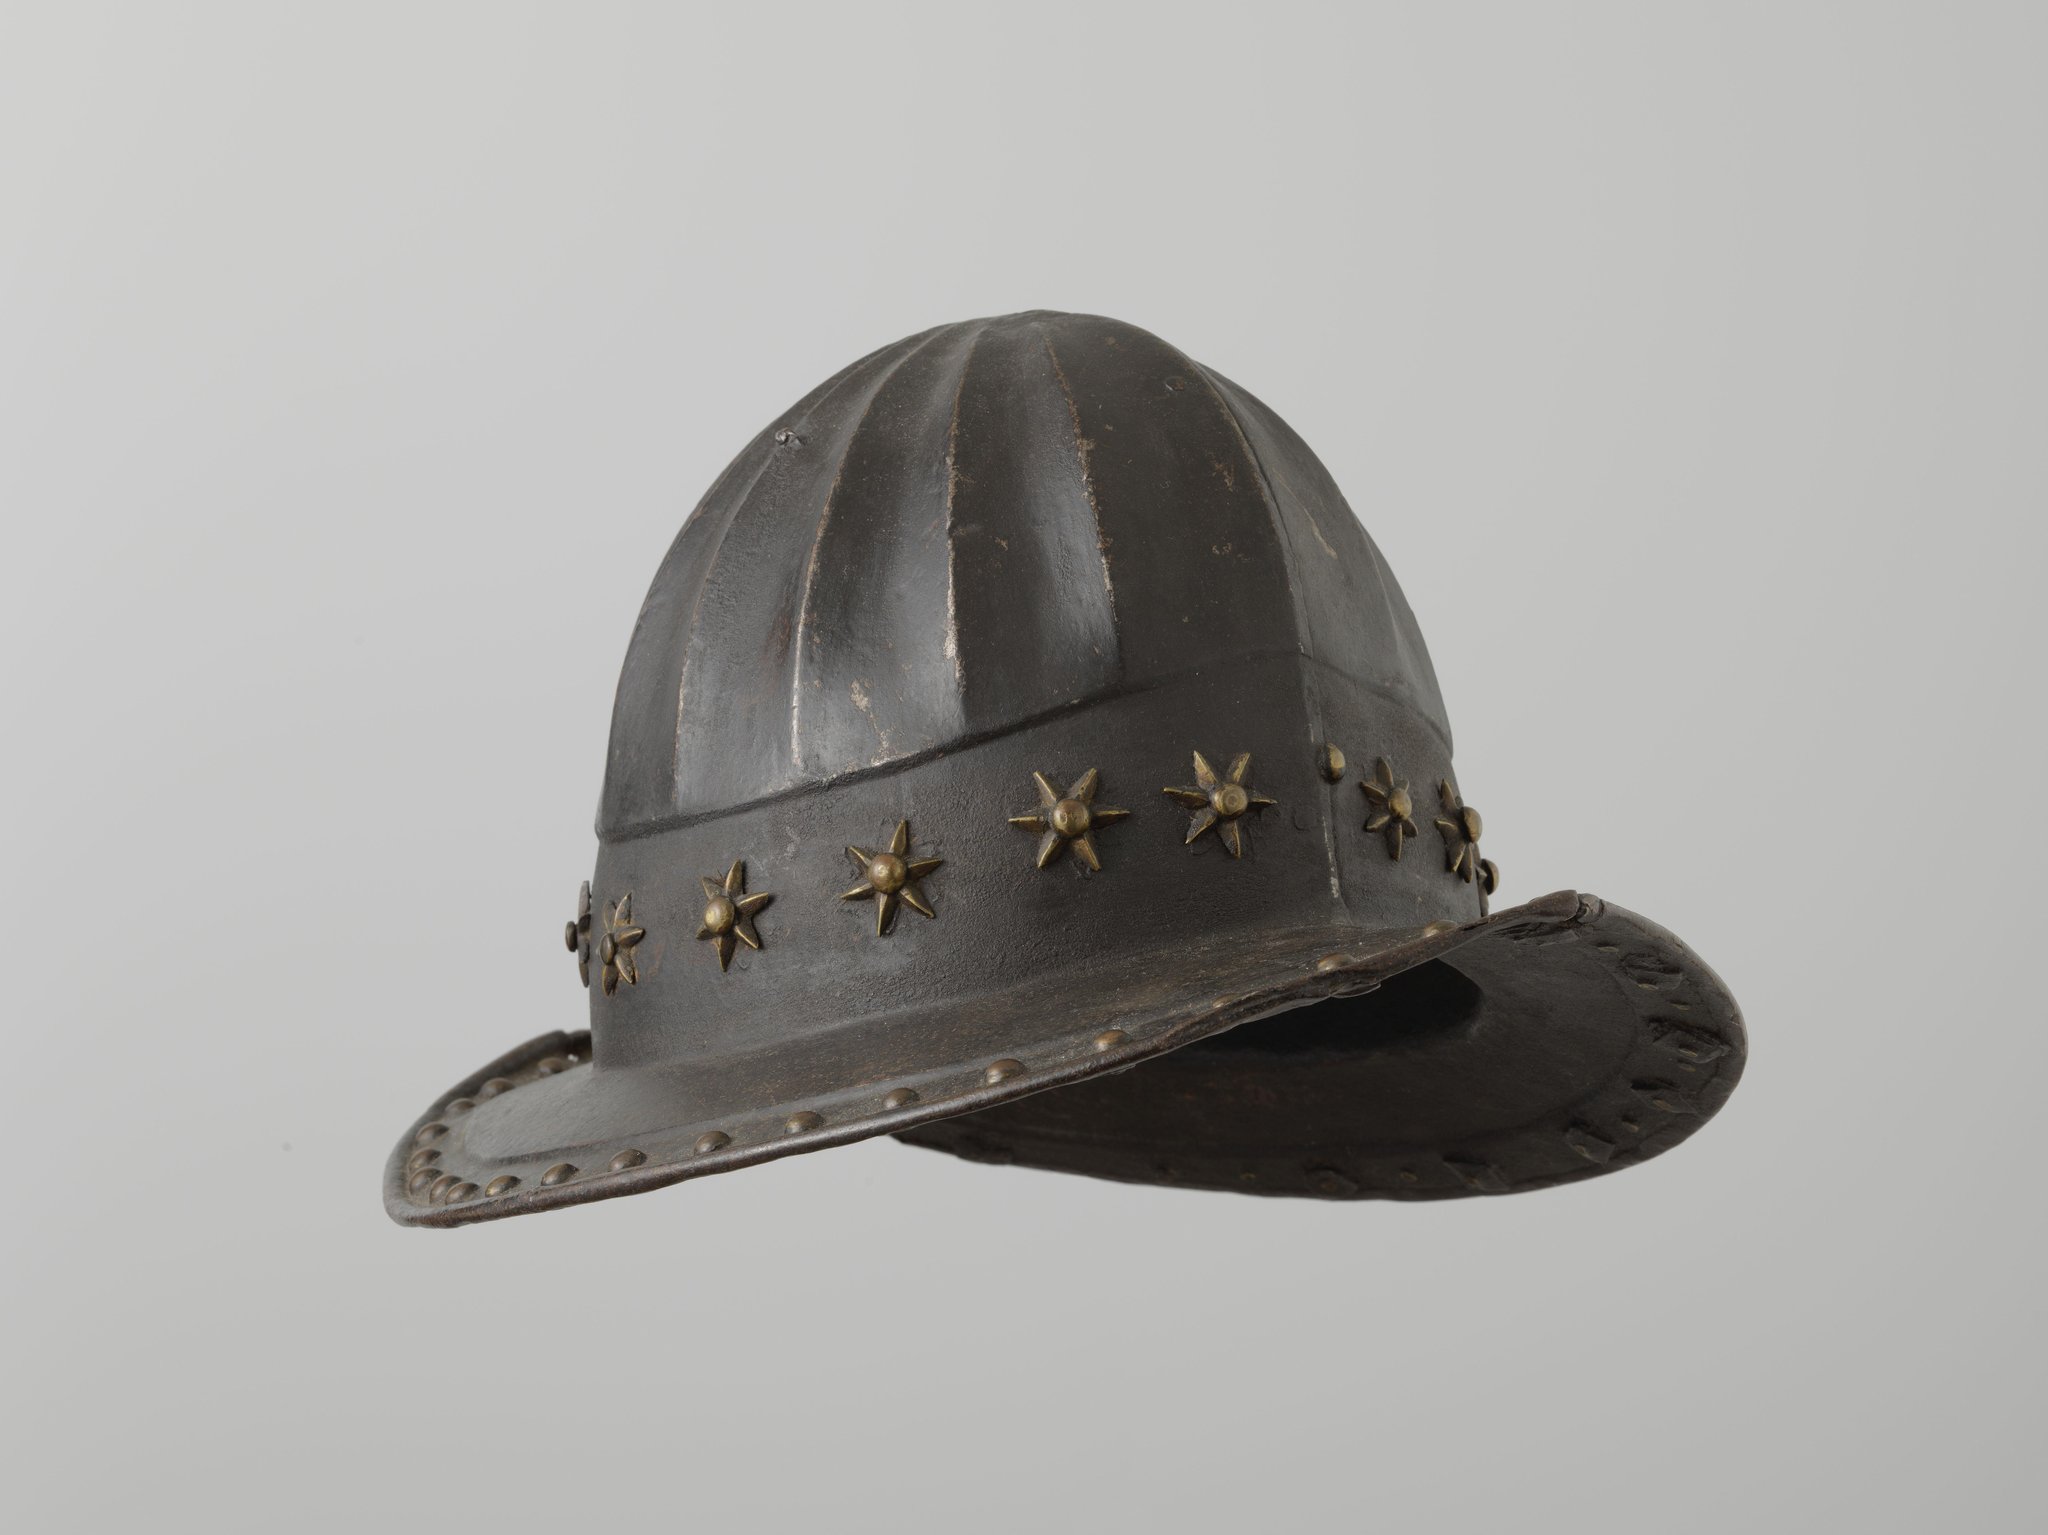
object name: stormhoed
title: Helm, stormhoed met koperen sterren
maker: Anonymous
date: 1600-1699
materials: copper, iron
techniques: striking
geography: europe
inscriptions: number: ‘1133 // 50’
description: Stormhoed, ijzer, zwart geverfd, de helmbol bestaat uit twee helften, met een diep afhangende rondom lopende klep, die van voren en achteren iets gebogen is. Op de helmbol radiale gleuven die tot halverwege de helmbol lopen, rondom de basis van de helmbol veertien koperen sterren en een klinknagel. Rondom de klep koperen klinknagels. Aan binnenzijde diverse klinknagels.